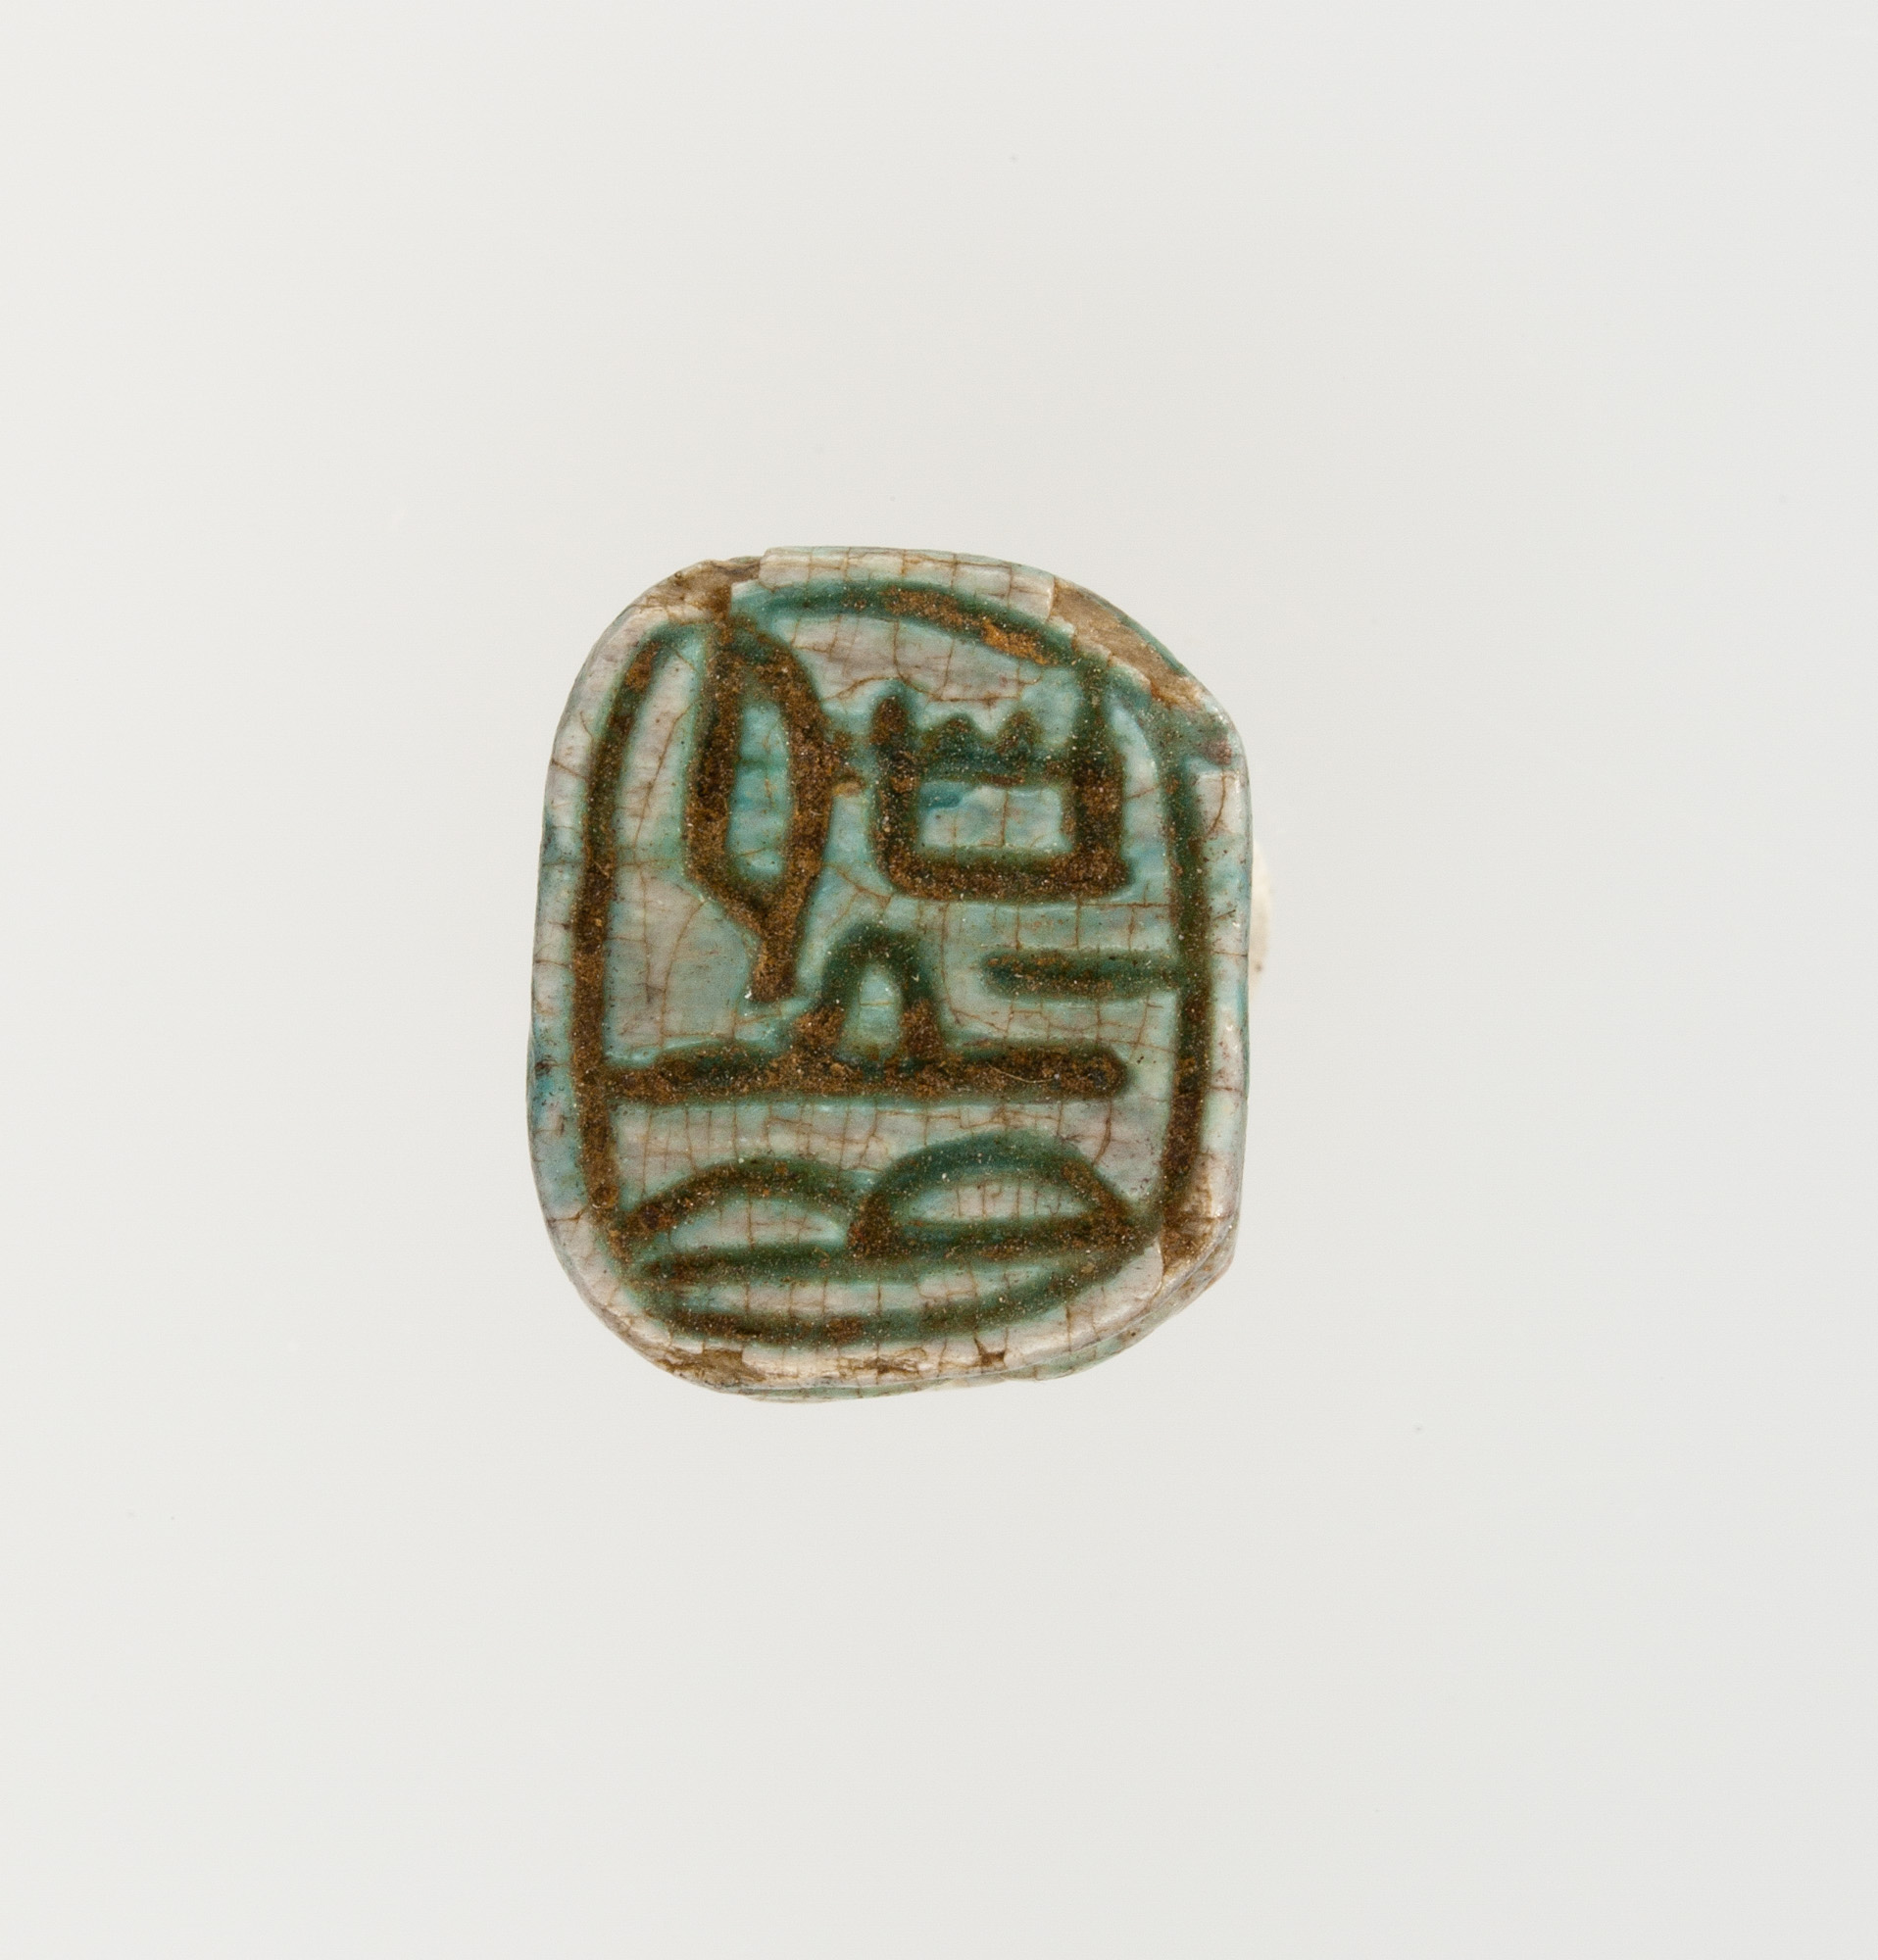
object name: scarab, amenhotep i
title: Scarab Inscribed with the Name Amenhotep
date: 1525-1504 BCE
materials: stone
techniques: glazing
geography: egypt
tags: hieroglyphs,scarabs